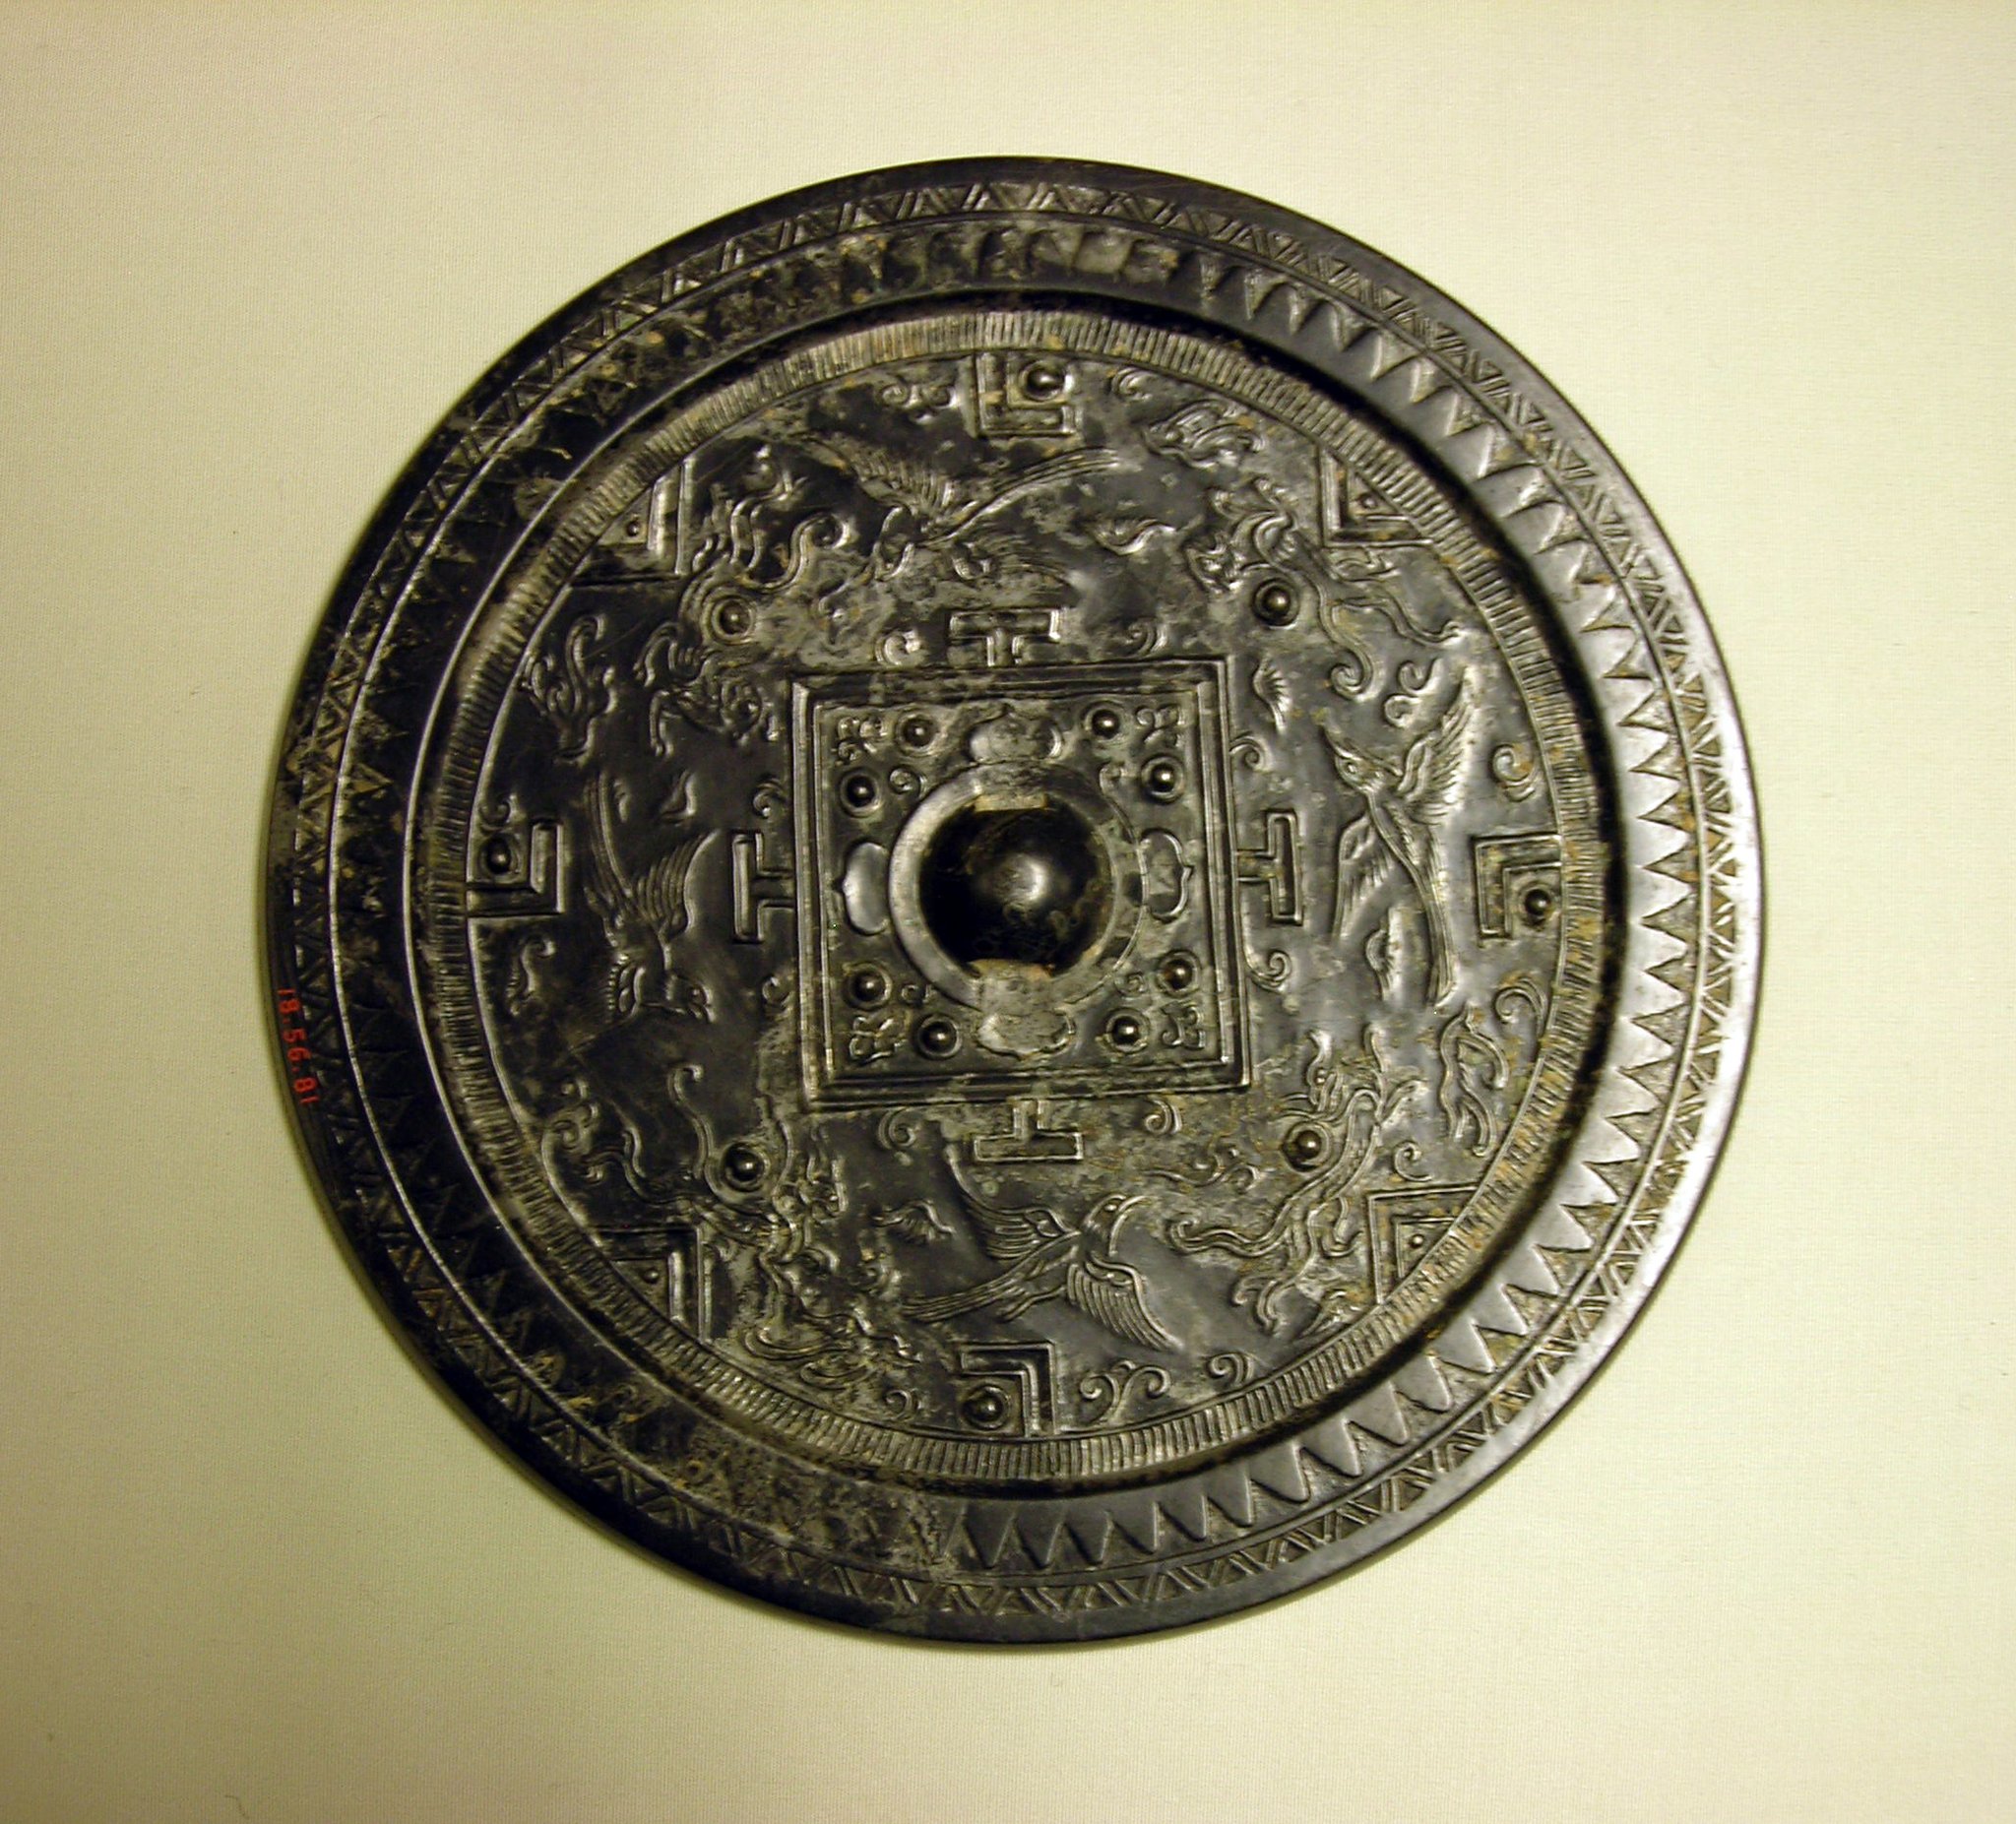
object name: mirror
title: Mirror with board game design and mythical creatures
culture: chinese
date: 100 BCE-100 CE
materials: bronze, patina